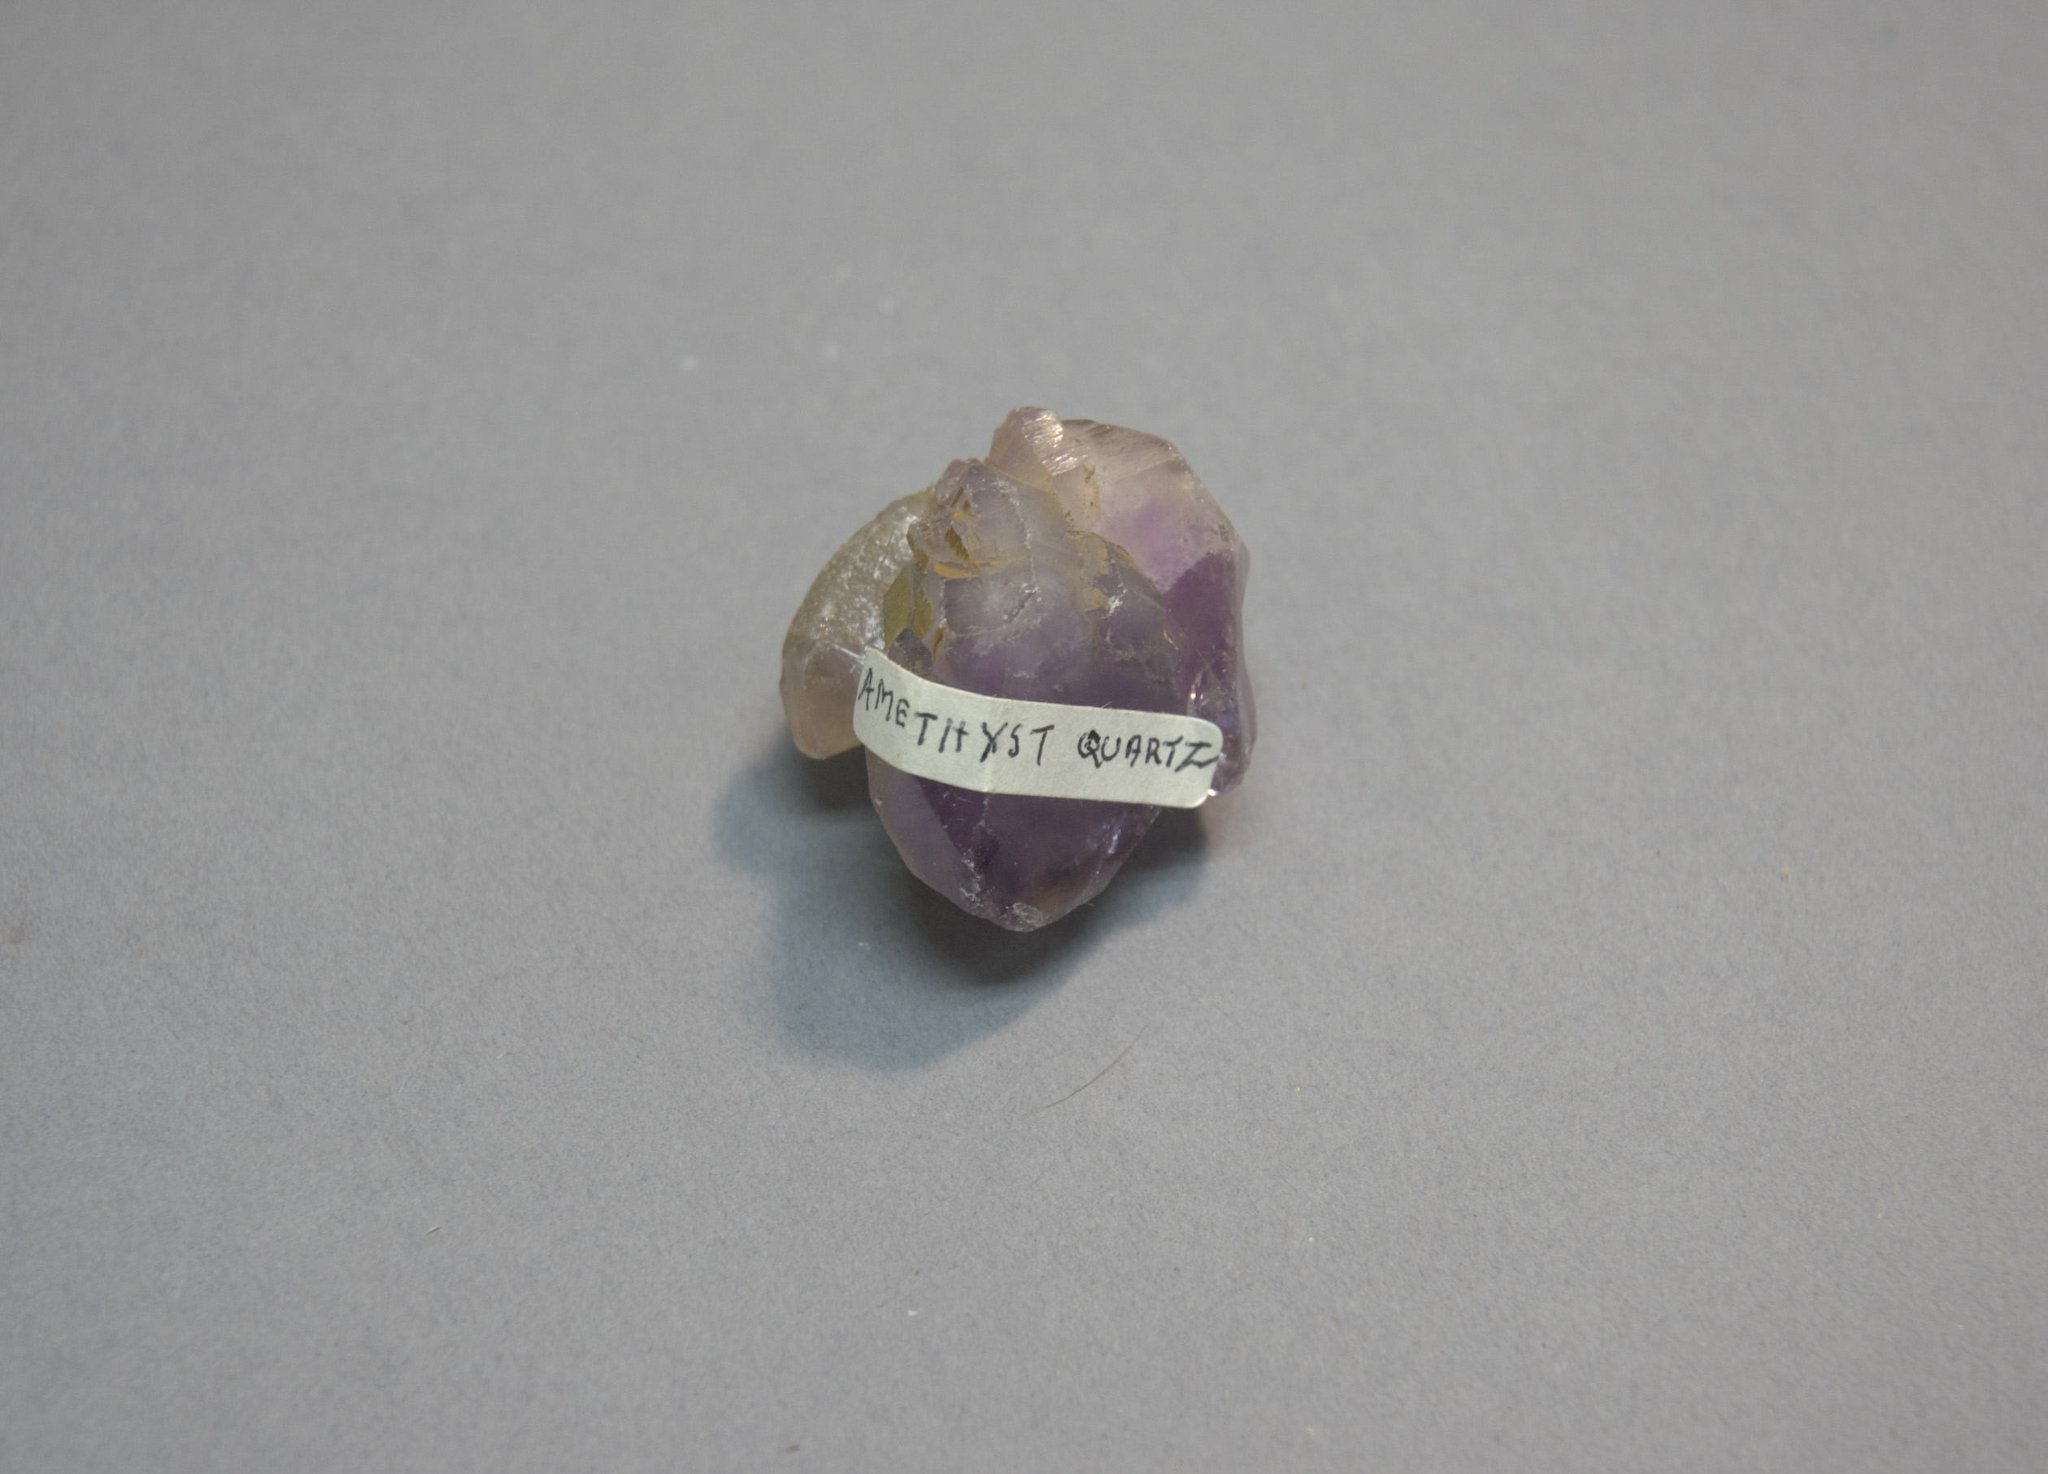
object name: jade carving material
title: Sample of Amethyst Quartz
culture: chinese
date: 1901-2000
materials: quartz